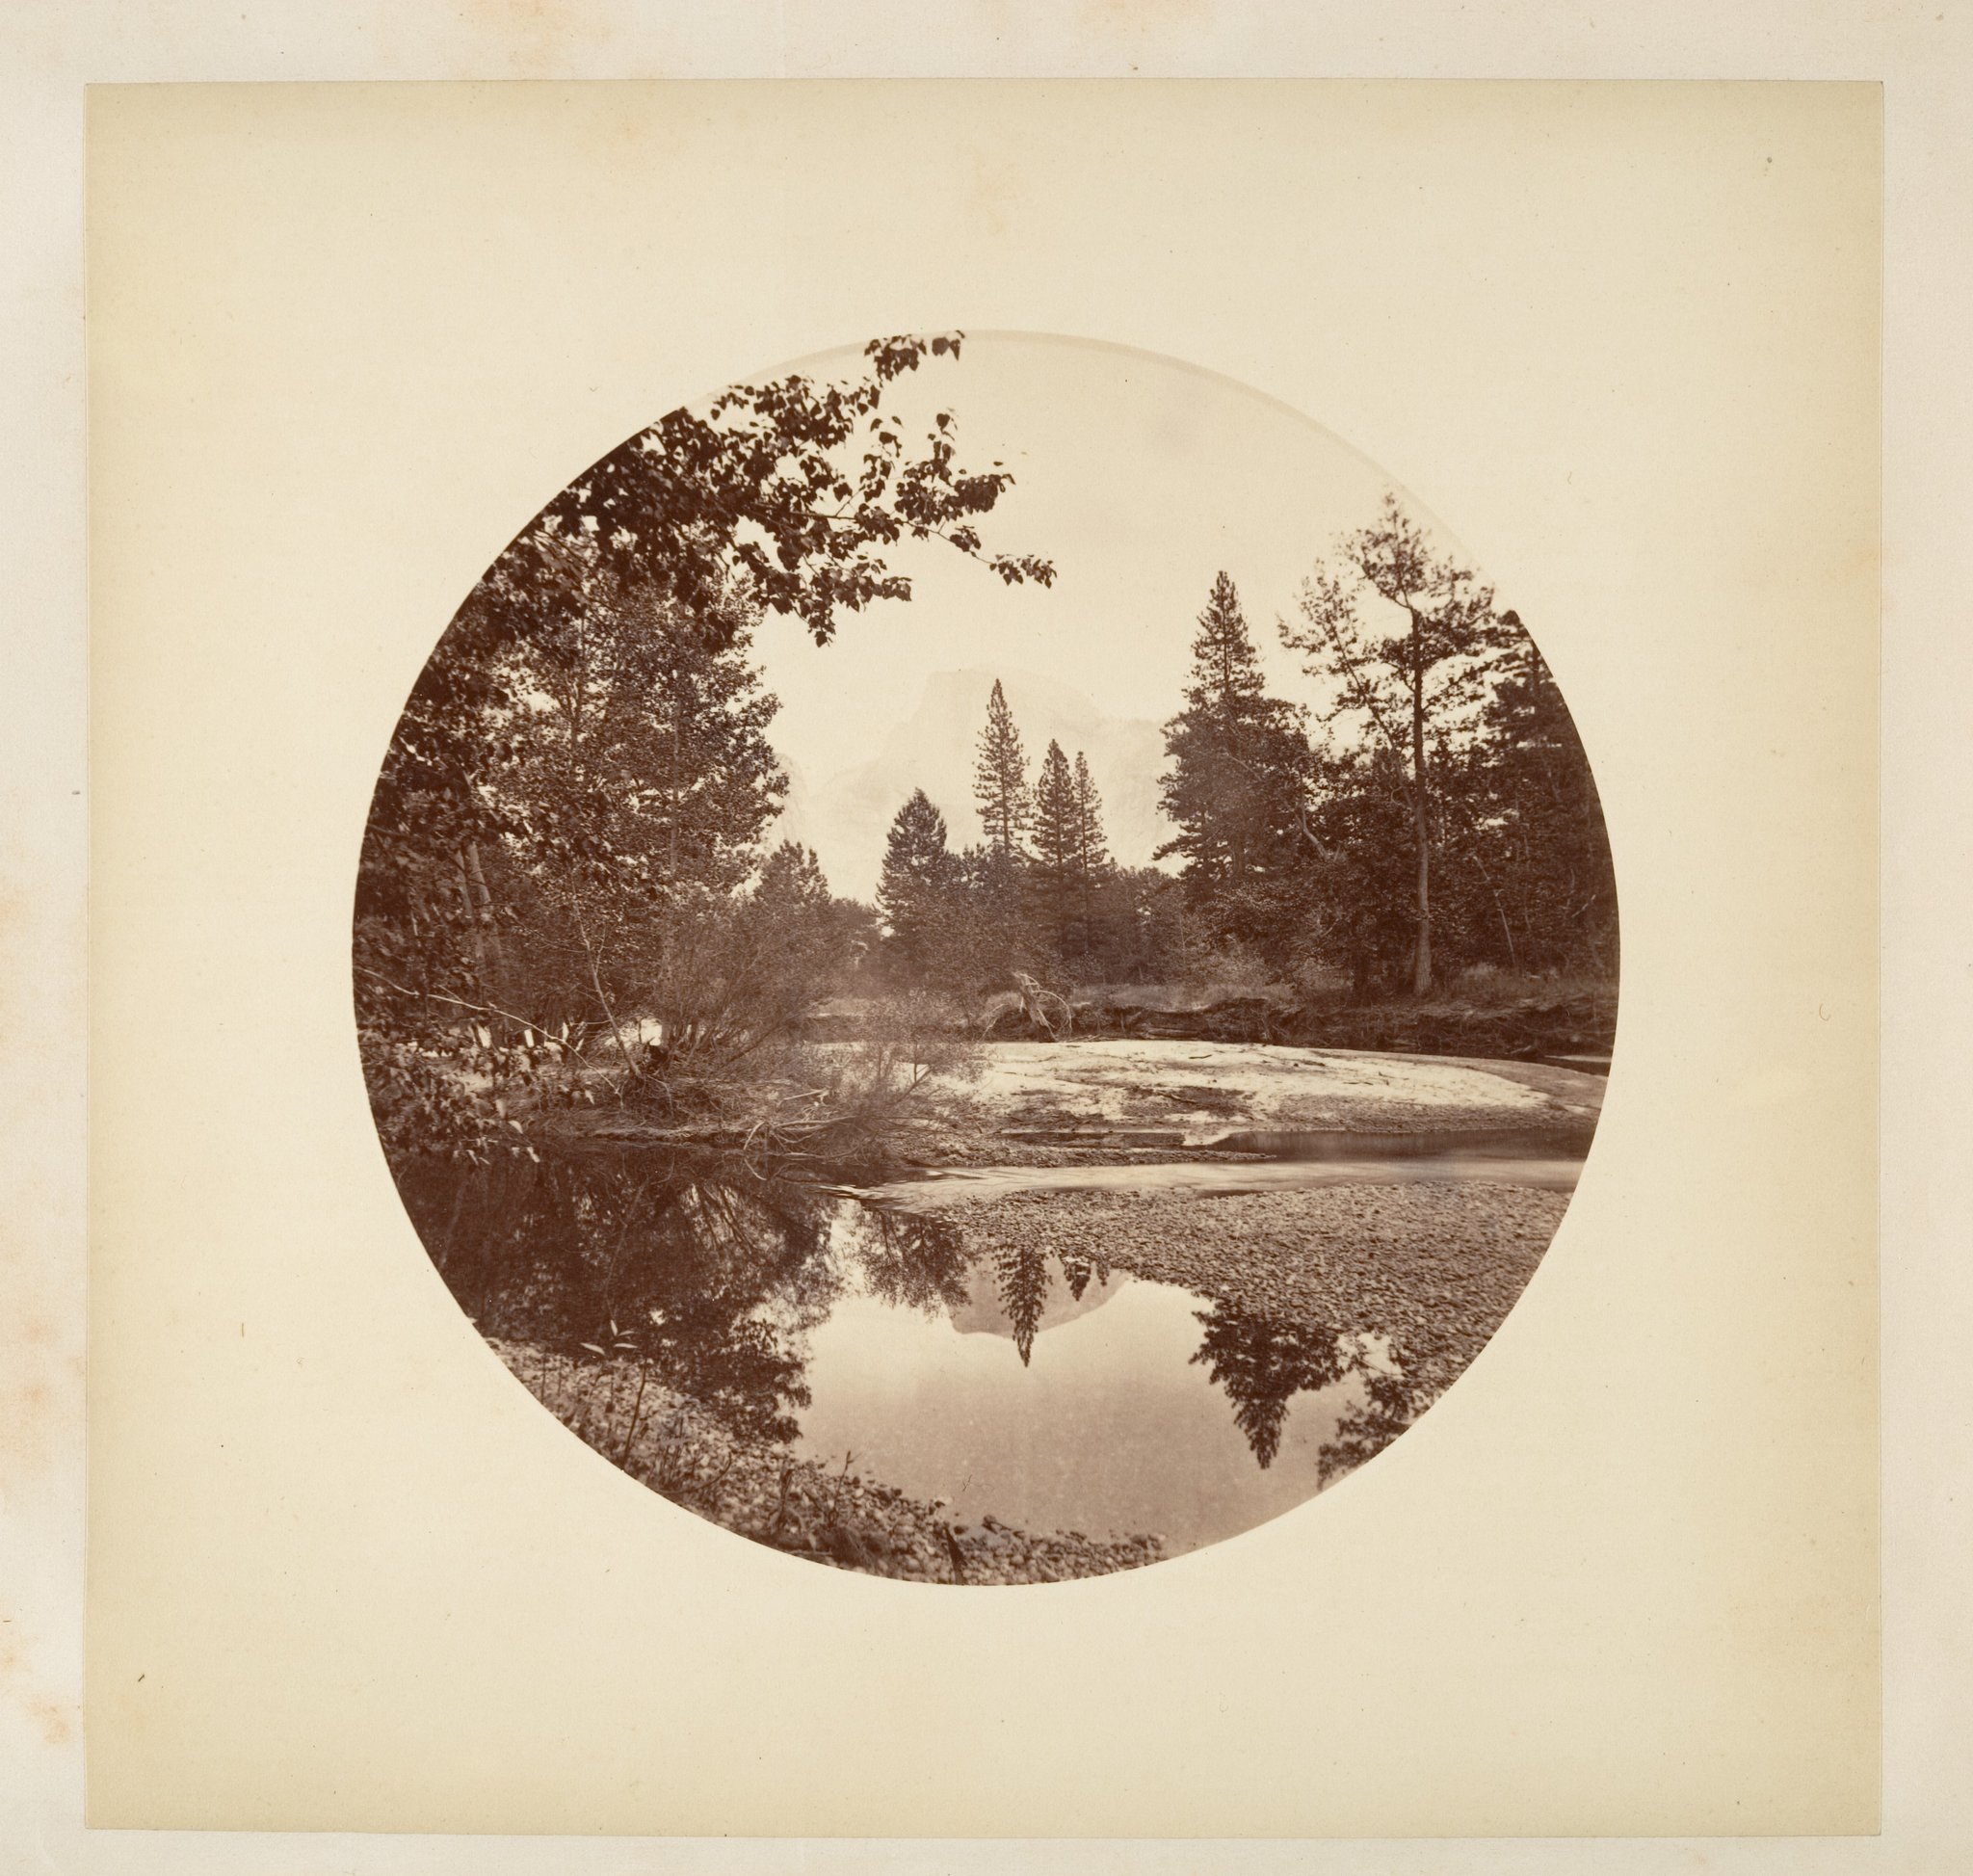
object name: photograph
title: [Yosemite National Park, California]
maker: carleton e. watkins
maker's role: artist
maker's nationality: american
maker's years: 1829-1916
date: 1878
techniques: albumen silver print, glass negative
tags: rivers,landscapes